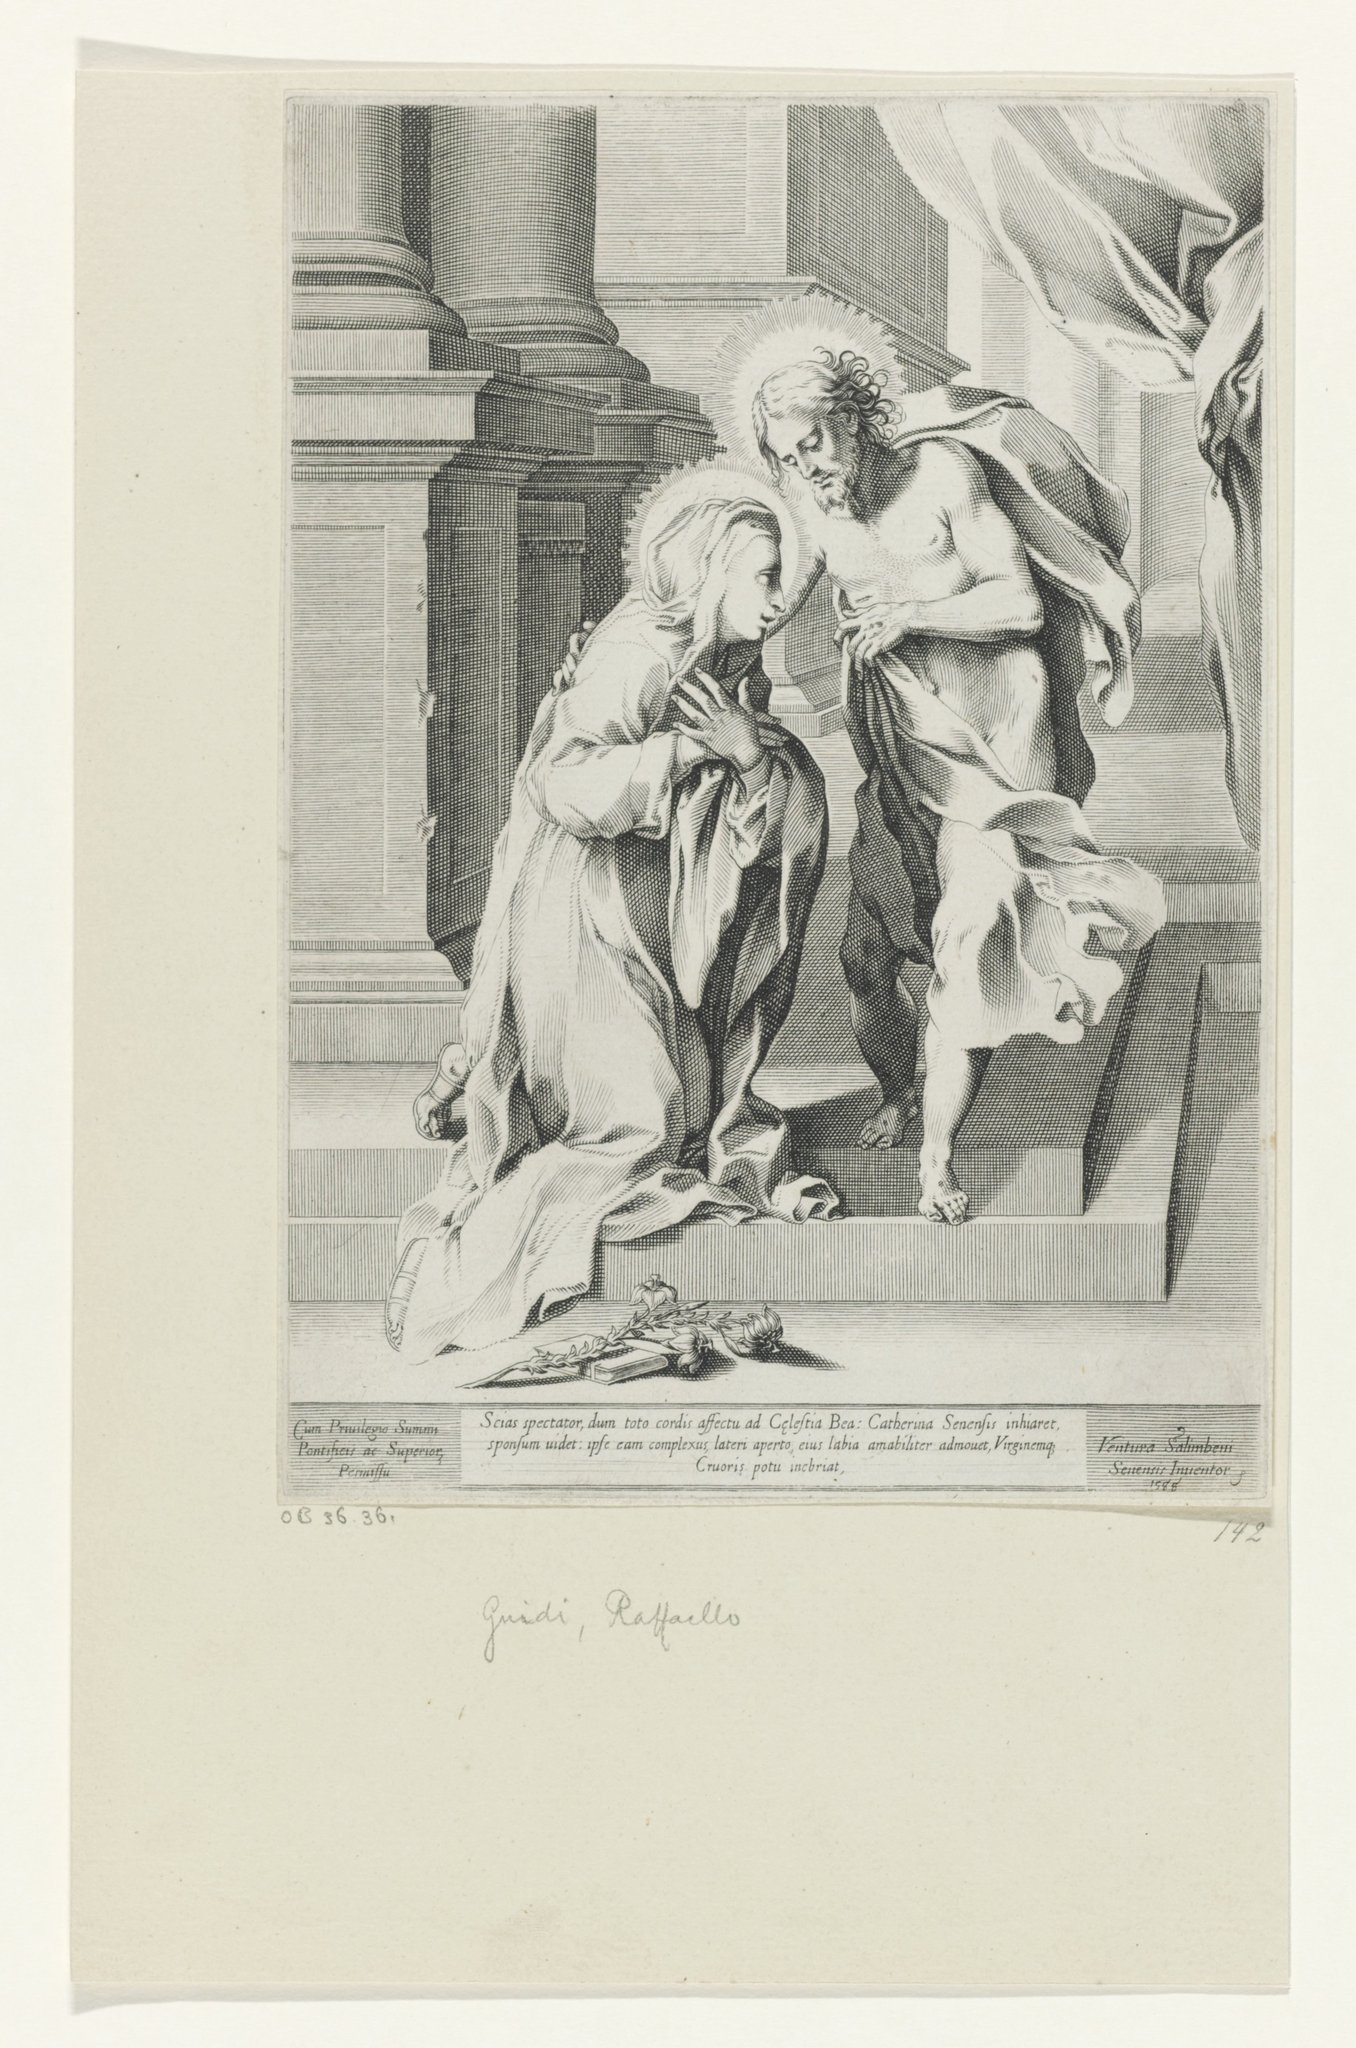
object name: print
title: Christus en de heilige Catharina van Siena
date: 1588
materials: paper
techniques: engraving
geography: italy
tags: the virgin and dominican tertiary, catherine of siena; possible attributes: book, cross, crown of thorns, crucifix, demon under foot, heart (with cross), lily, plague-stricken, ring, rosary, stigmata, adult christ together with apostles, evangelists, saints, etc.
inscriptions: collector's mark: Lugt 240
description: De heilige Catharina van Siena knielt voor Christus. Christus legt een hand op haar schouder. Op de voorgrond liggen een lelietak en een boek.